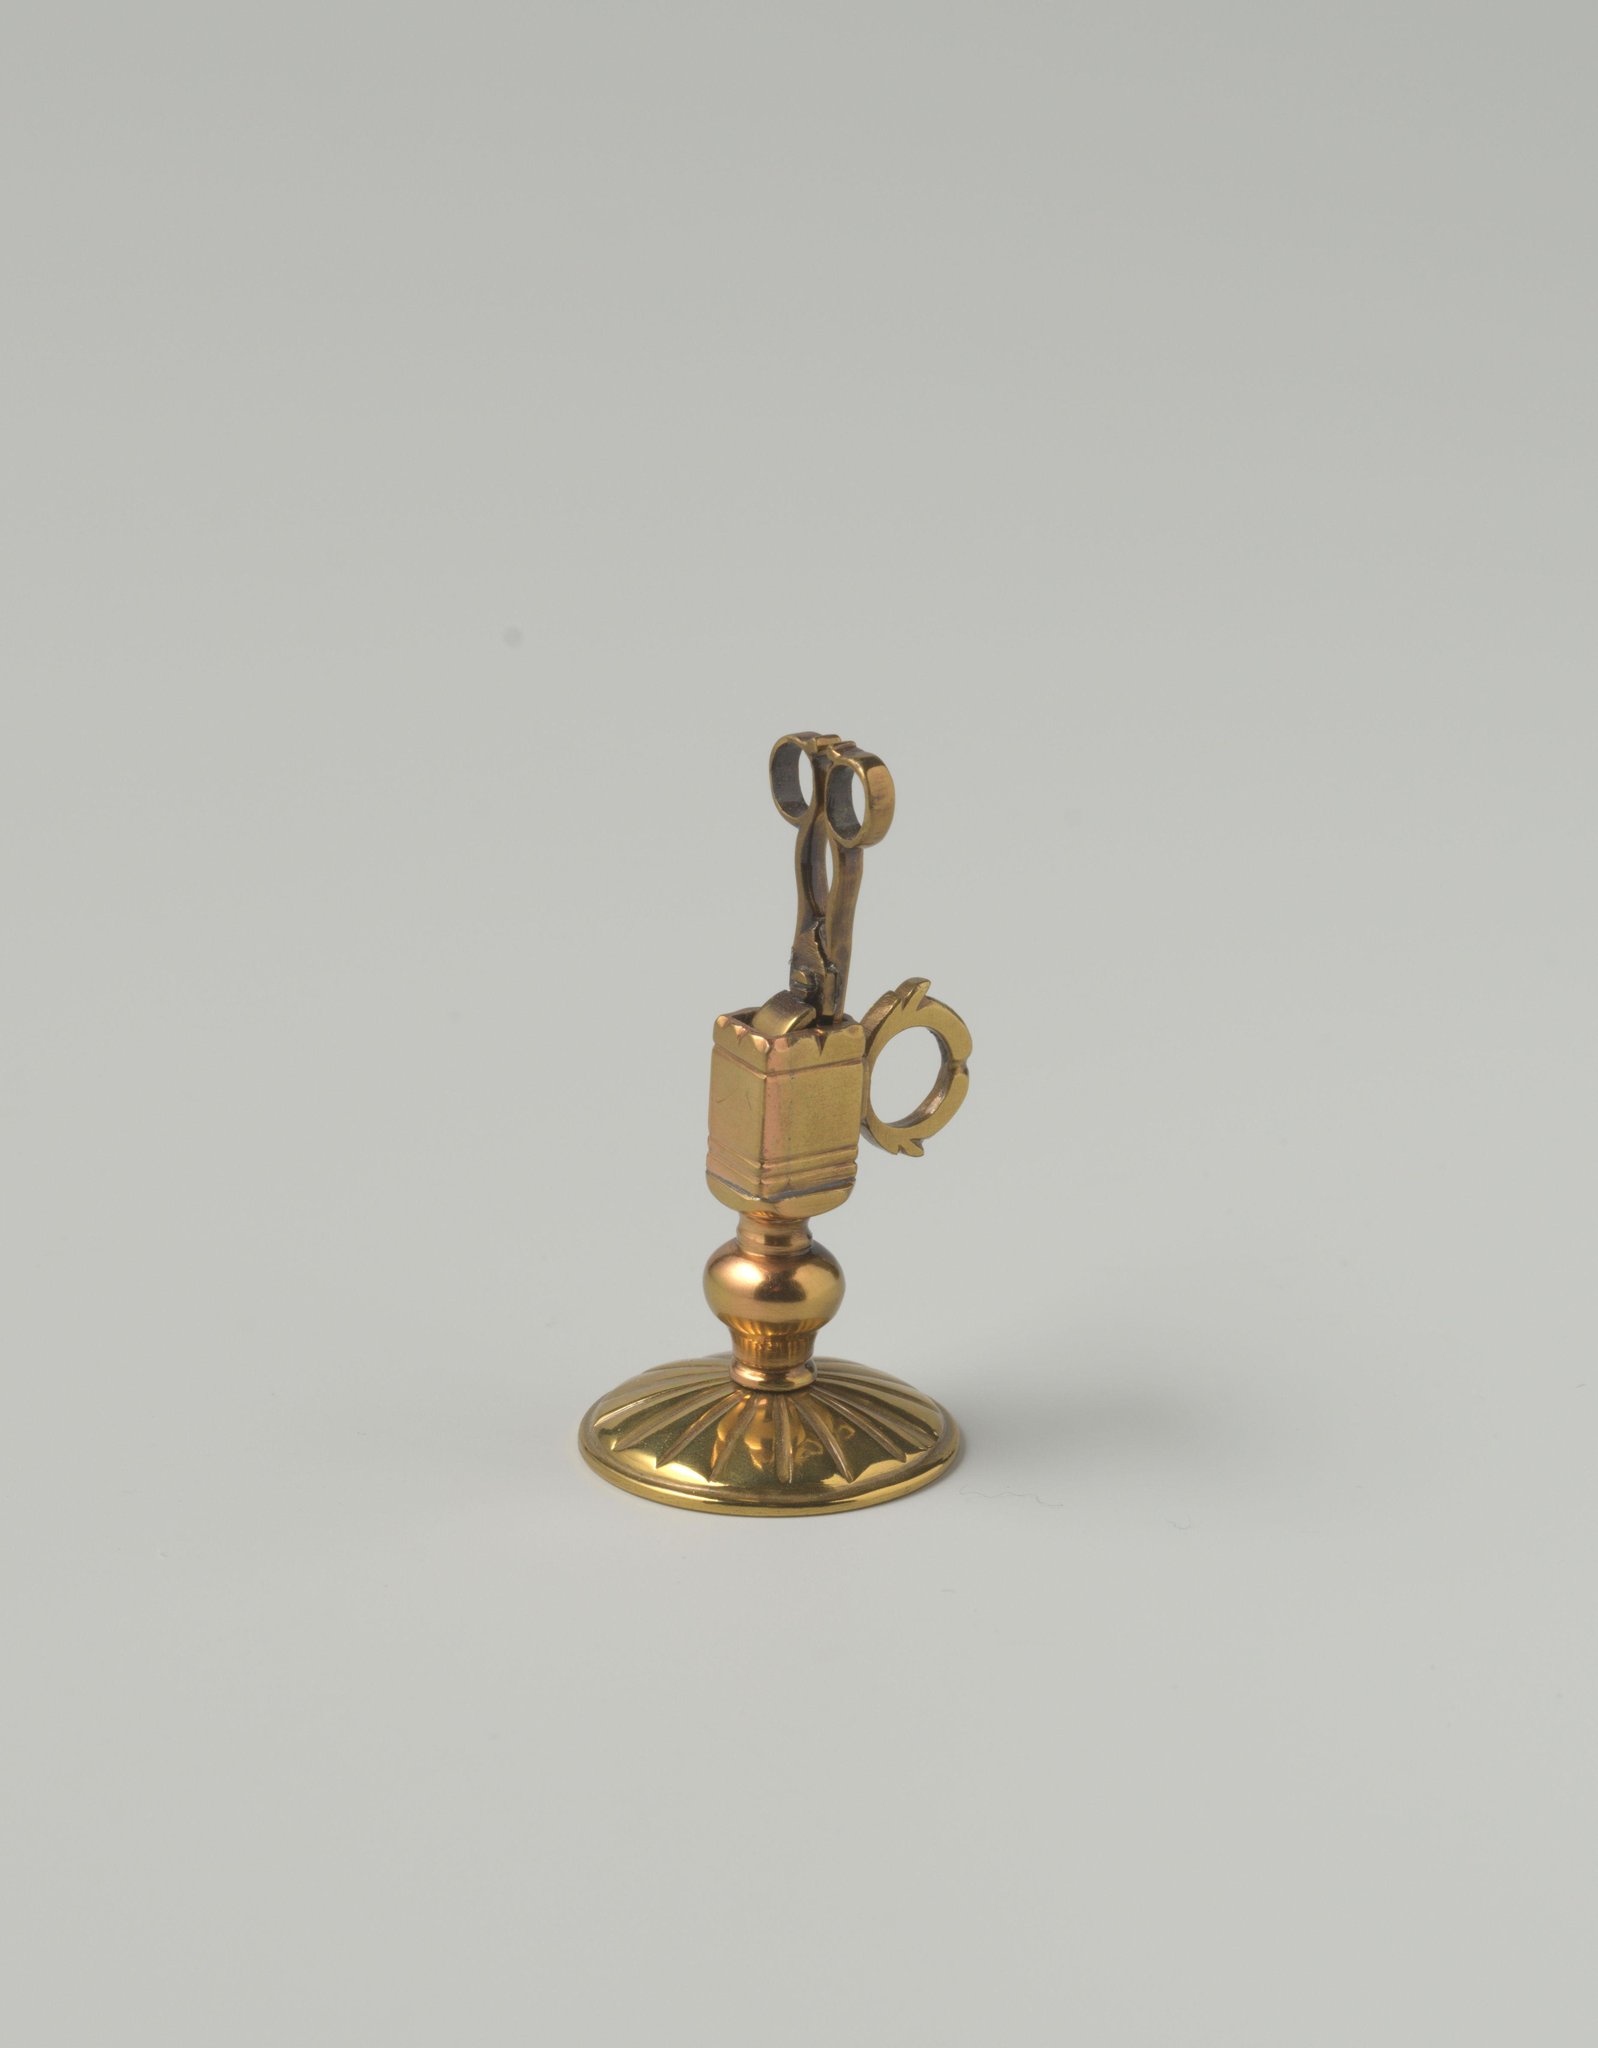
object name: miniature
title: Standaard voor kaarsensnuiter, rechthoekige geprofileerde houder met ringvormig handvat en gaatje, op massieve baluster stam en afschroefbare brede voet met groeven versierd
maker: Anonymous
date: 1690-1710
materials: copper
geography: amsterdam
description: Standaard voor kaarsensnuiter, rechthoekige geprofileerde houder met ringvormig handvat en gaatje, op massieve baluster stam en afschroefbare brede voet met groeven versierd.